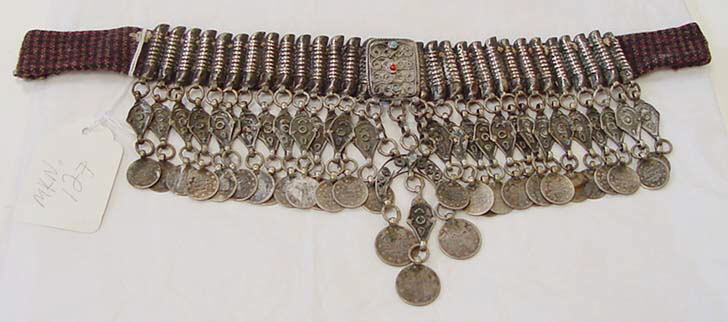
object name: necklace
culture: moroccan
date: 1801-1900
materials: enamel, metal, wool